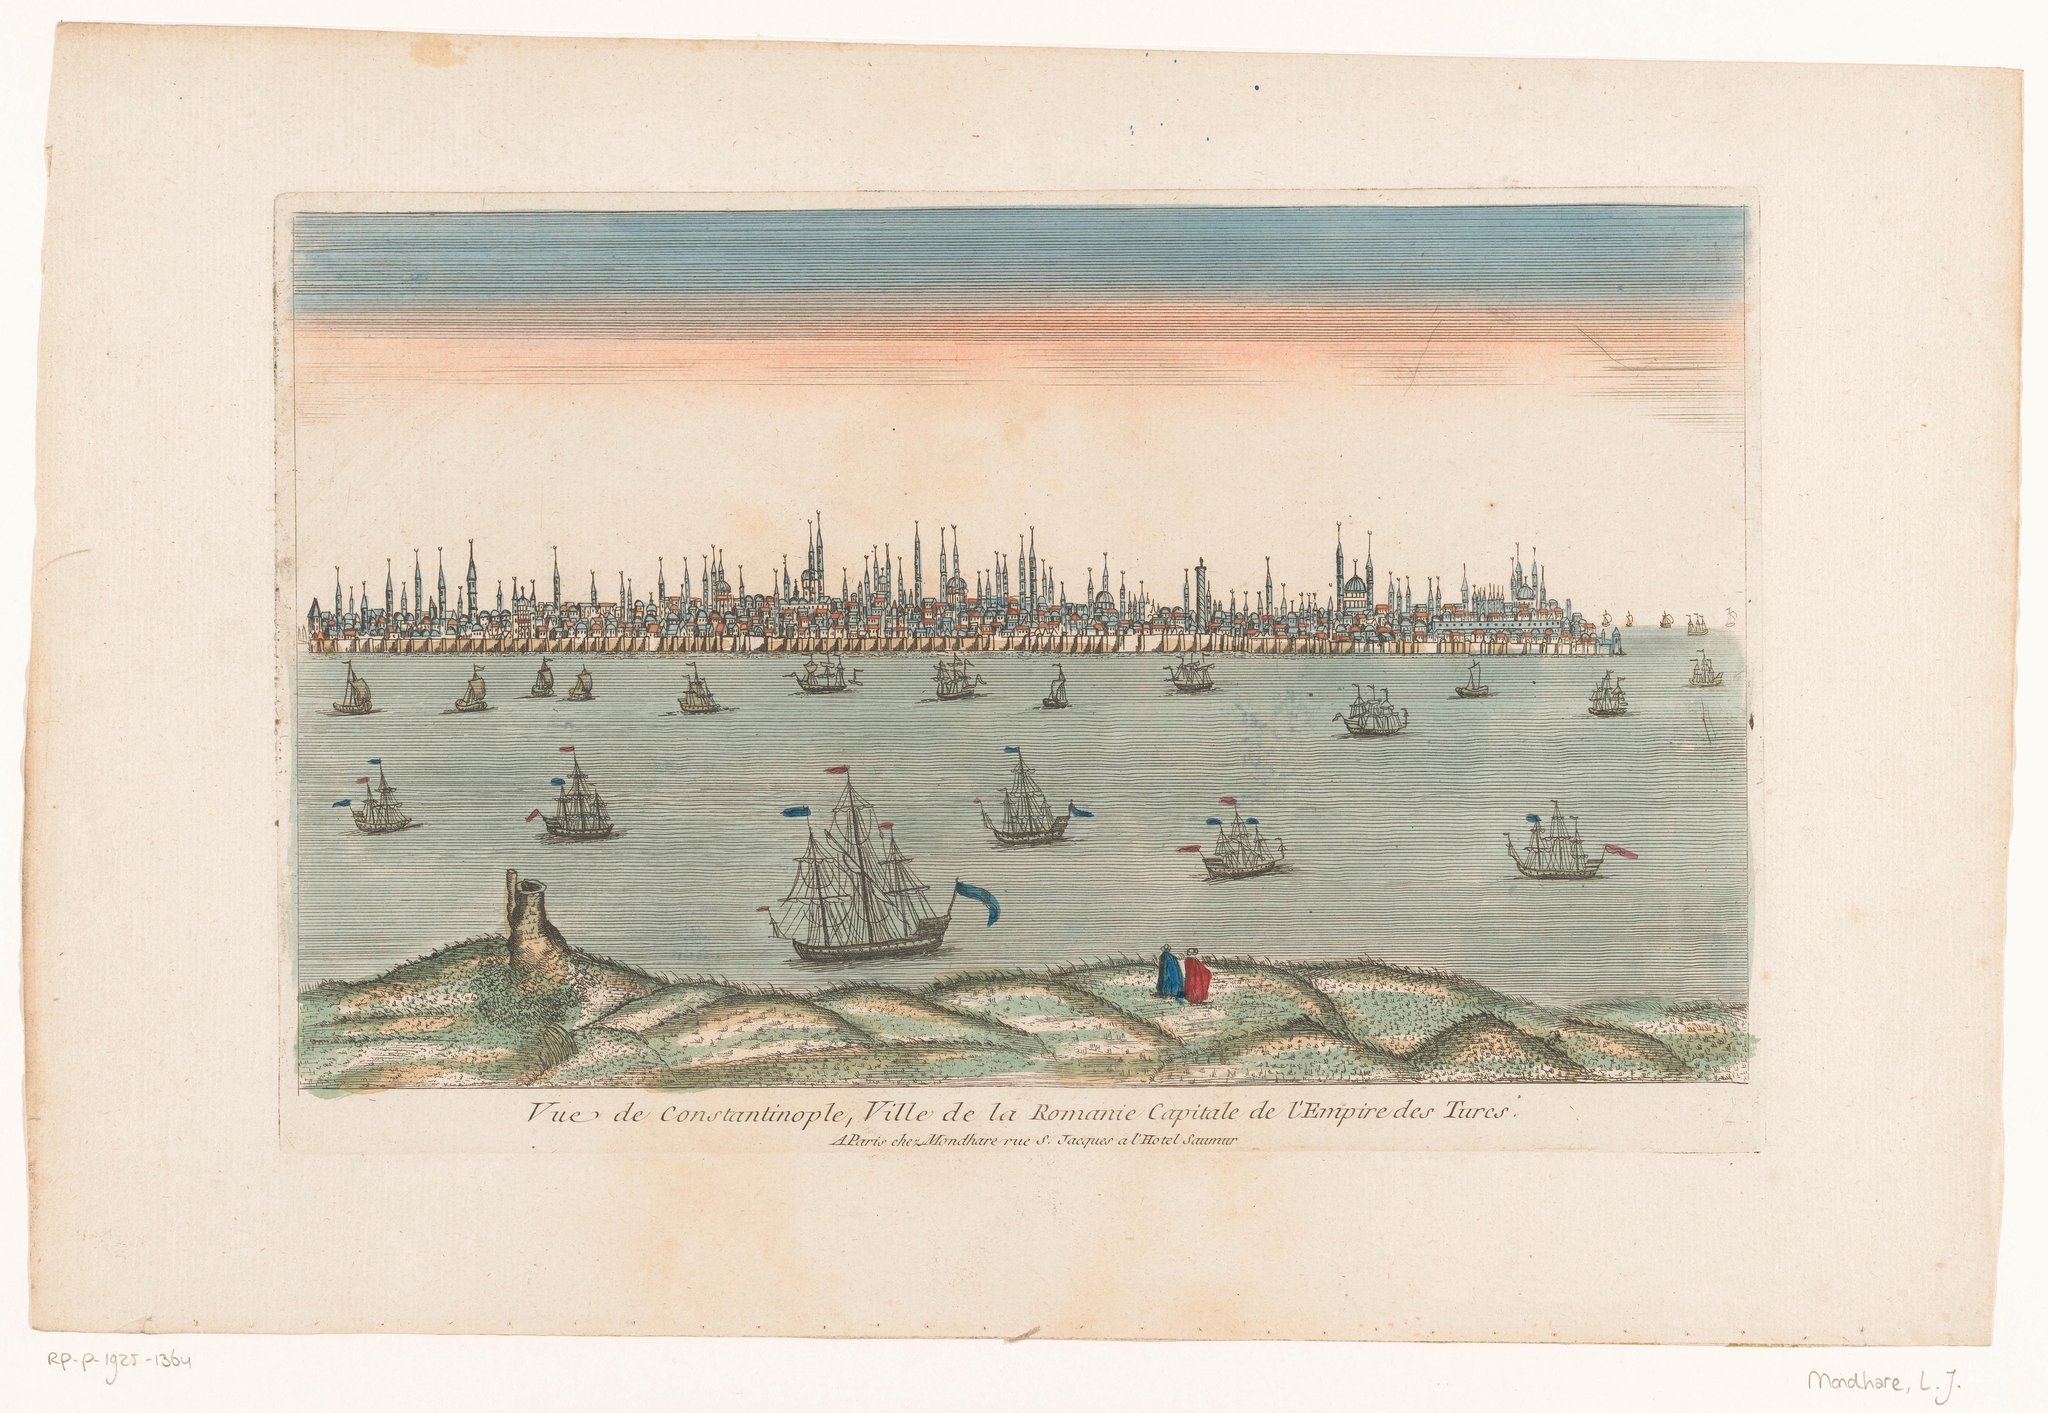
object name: print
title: Vue de Constantinople, ville de la Romanie capitale de l'empire des Turcs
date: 1759-1796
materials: paper, watercolor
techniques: brush, etching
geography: paris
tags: sailing-ship, sailing-boat, city-view in general; 'veduta' (+ city(-scape) with figures, staffage), canals, waters (in city) (+ city(-scape) with figures, staffage)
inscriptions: watermark, collector's mark: Lugt 2166